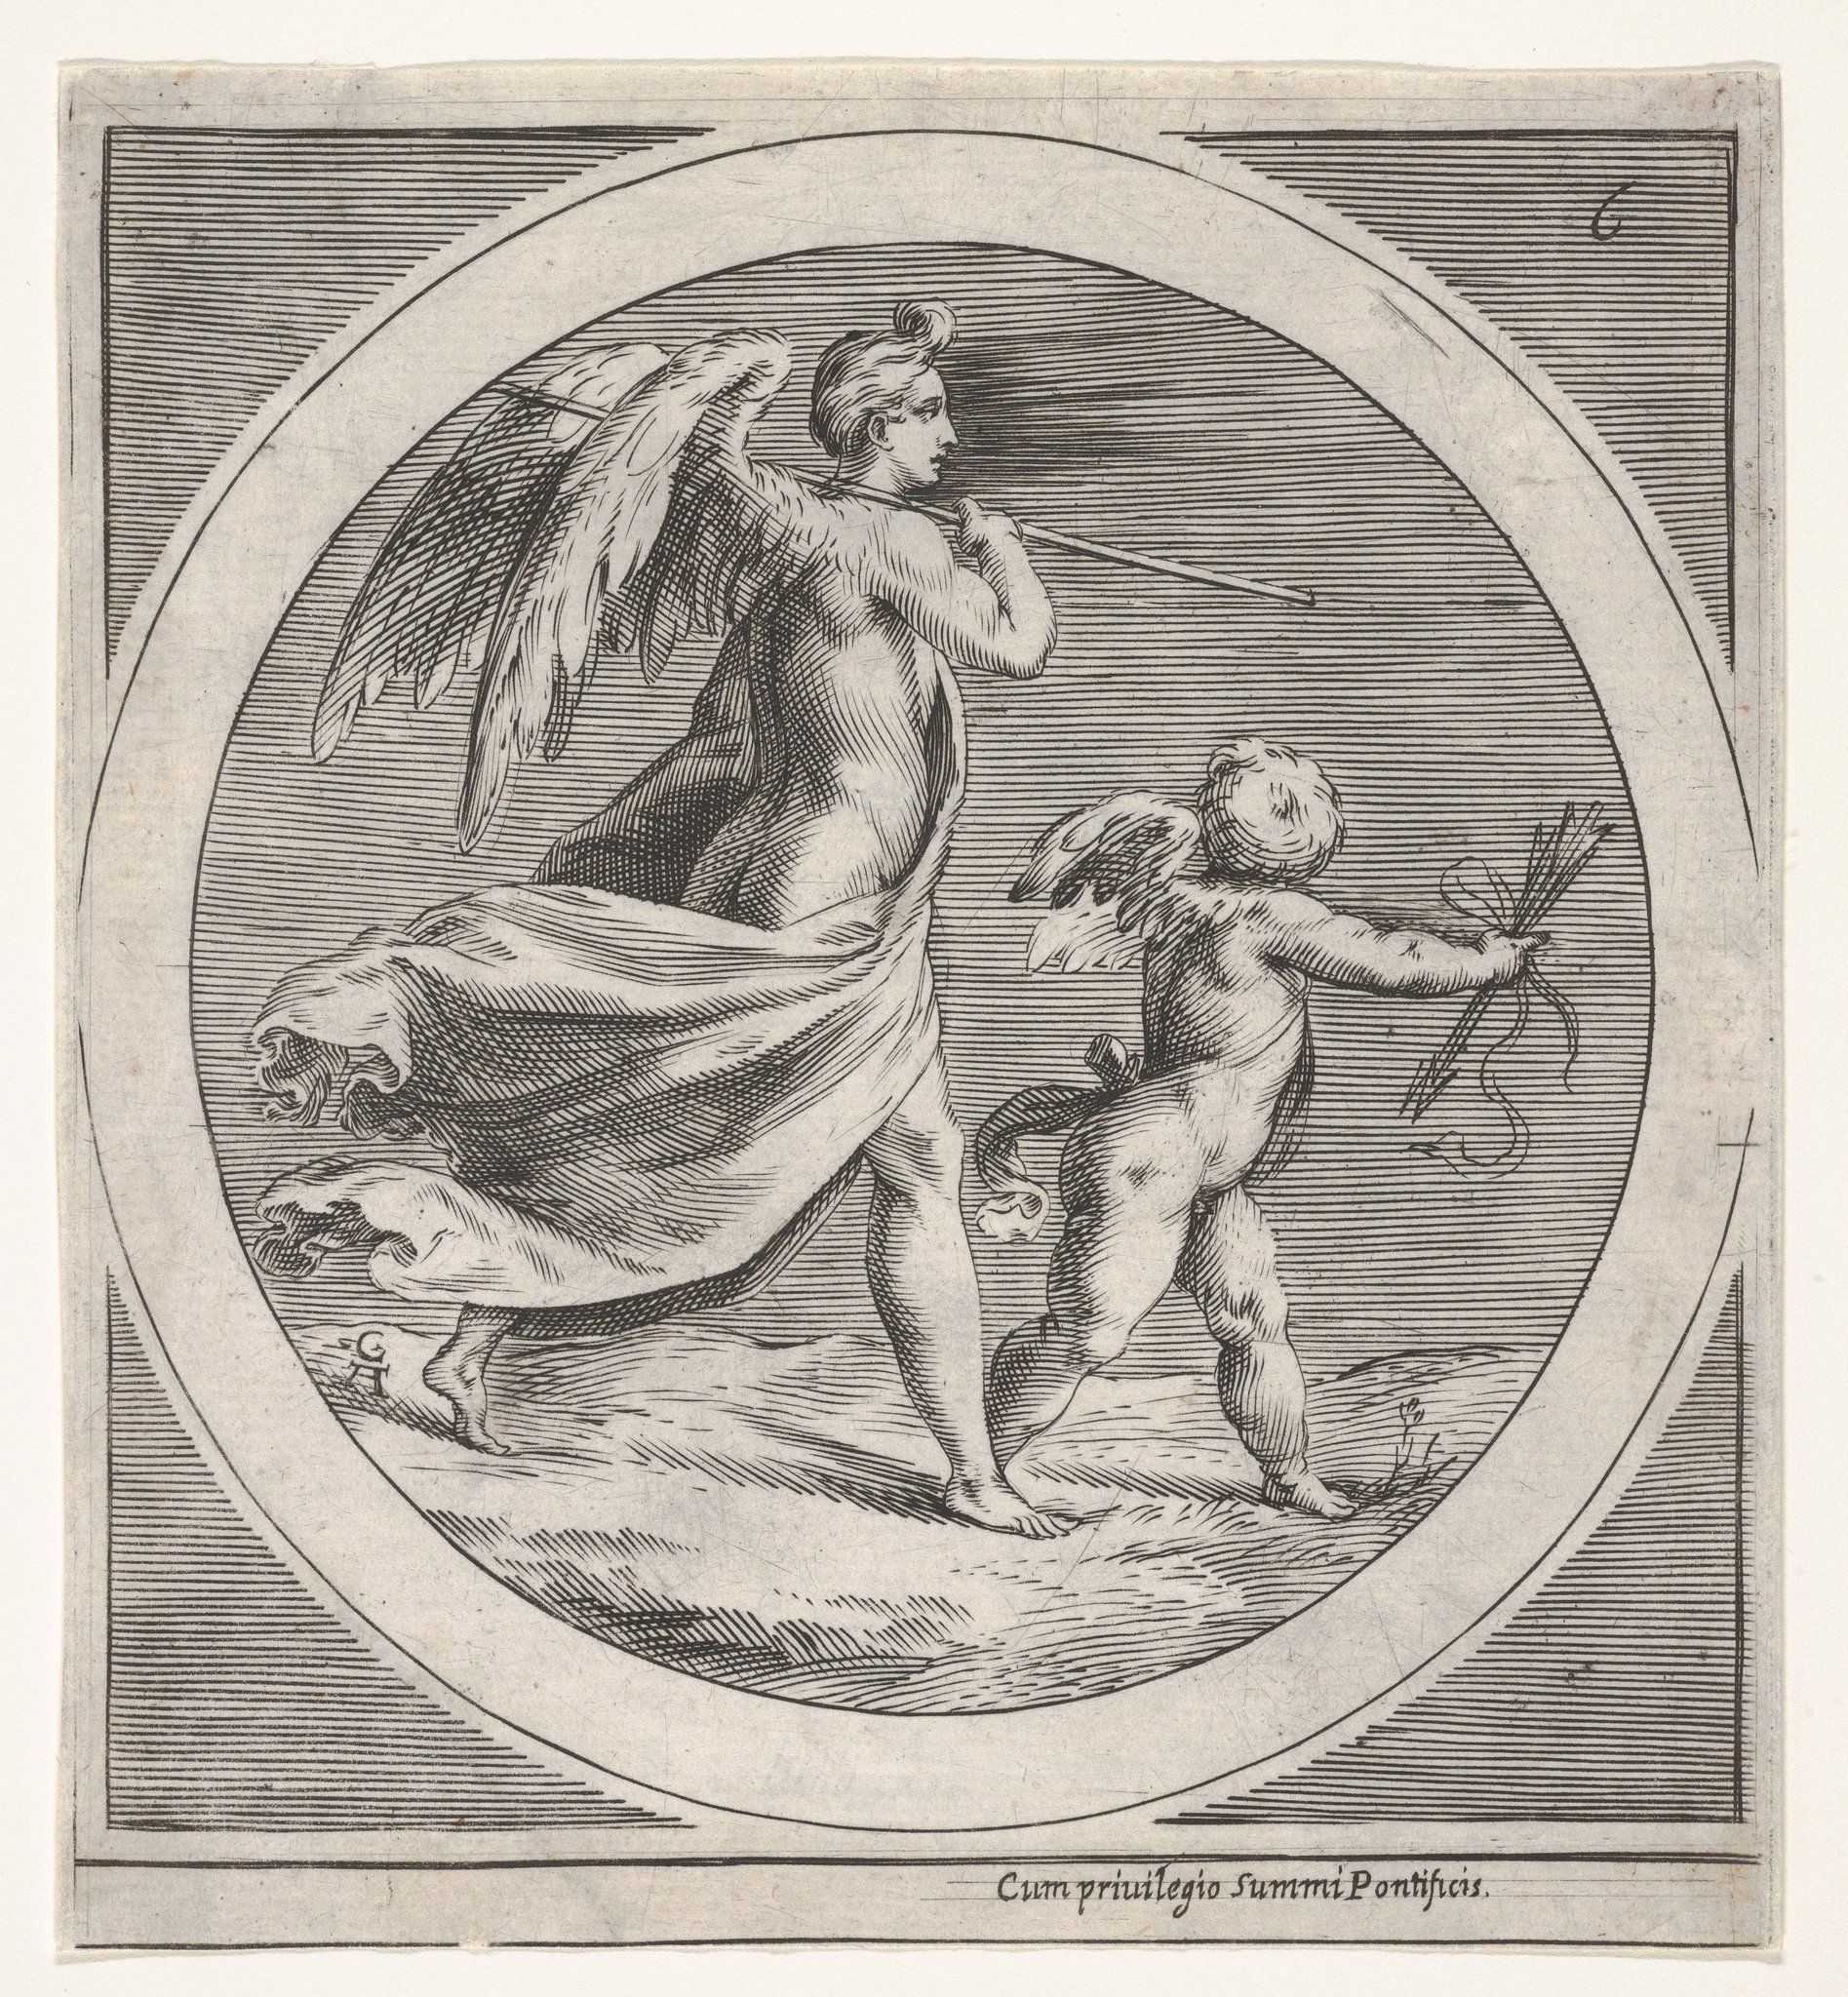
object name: print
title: Winged female figure, draped and carrying a staff, striding behind a winged putto, who twists to look over his left shoulder, a round composition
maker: Anonymous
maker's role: artist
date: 1550-1600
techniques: engraving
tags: cupid